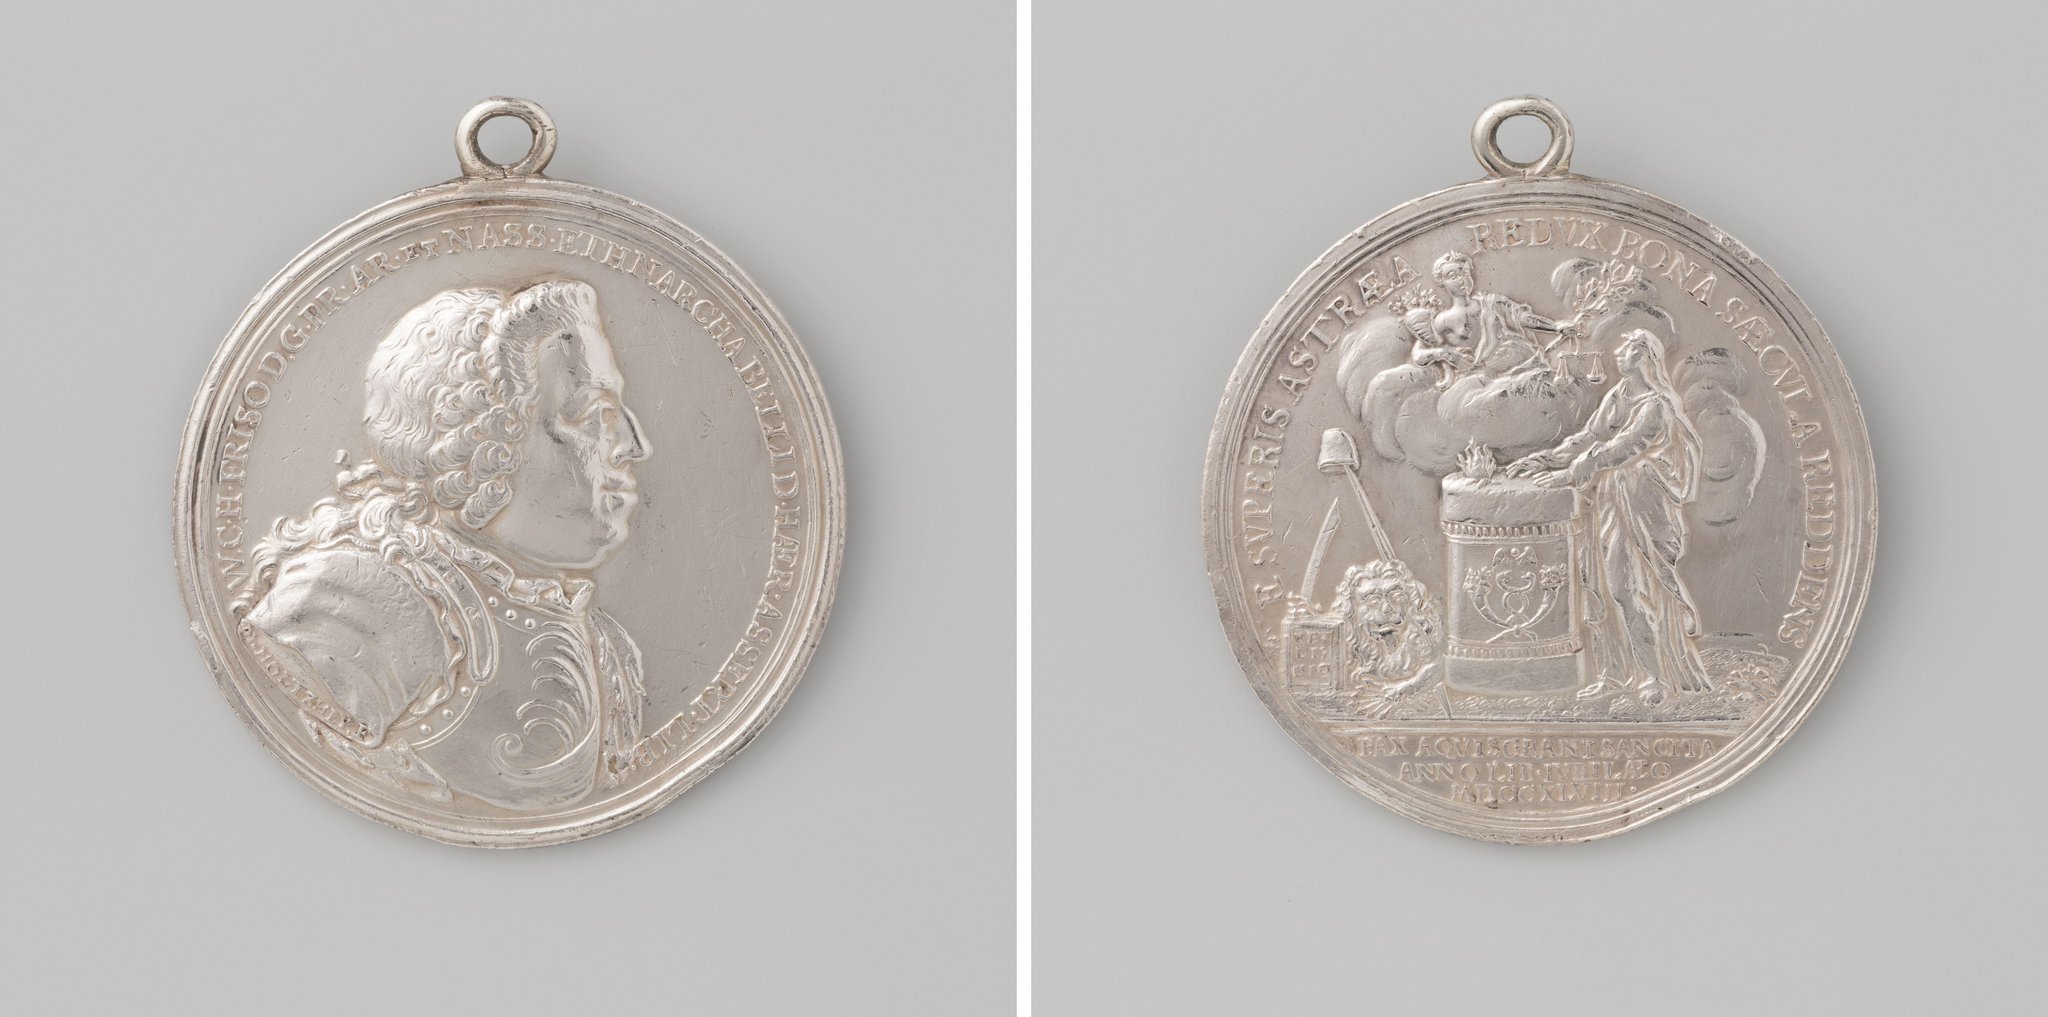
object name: history medal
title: Vrede te Aken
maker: martinus holtzhey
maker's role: medailleur, muntmaker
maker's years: 1697-1764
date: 1748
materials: silver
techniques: striking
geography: amsterdam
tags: aken, vrede van aken (1748)